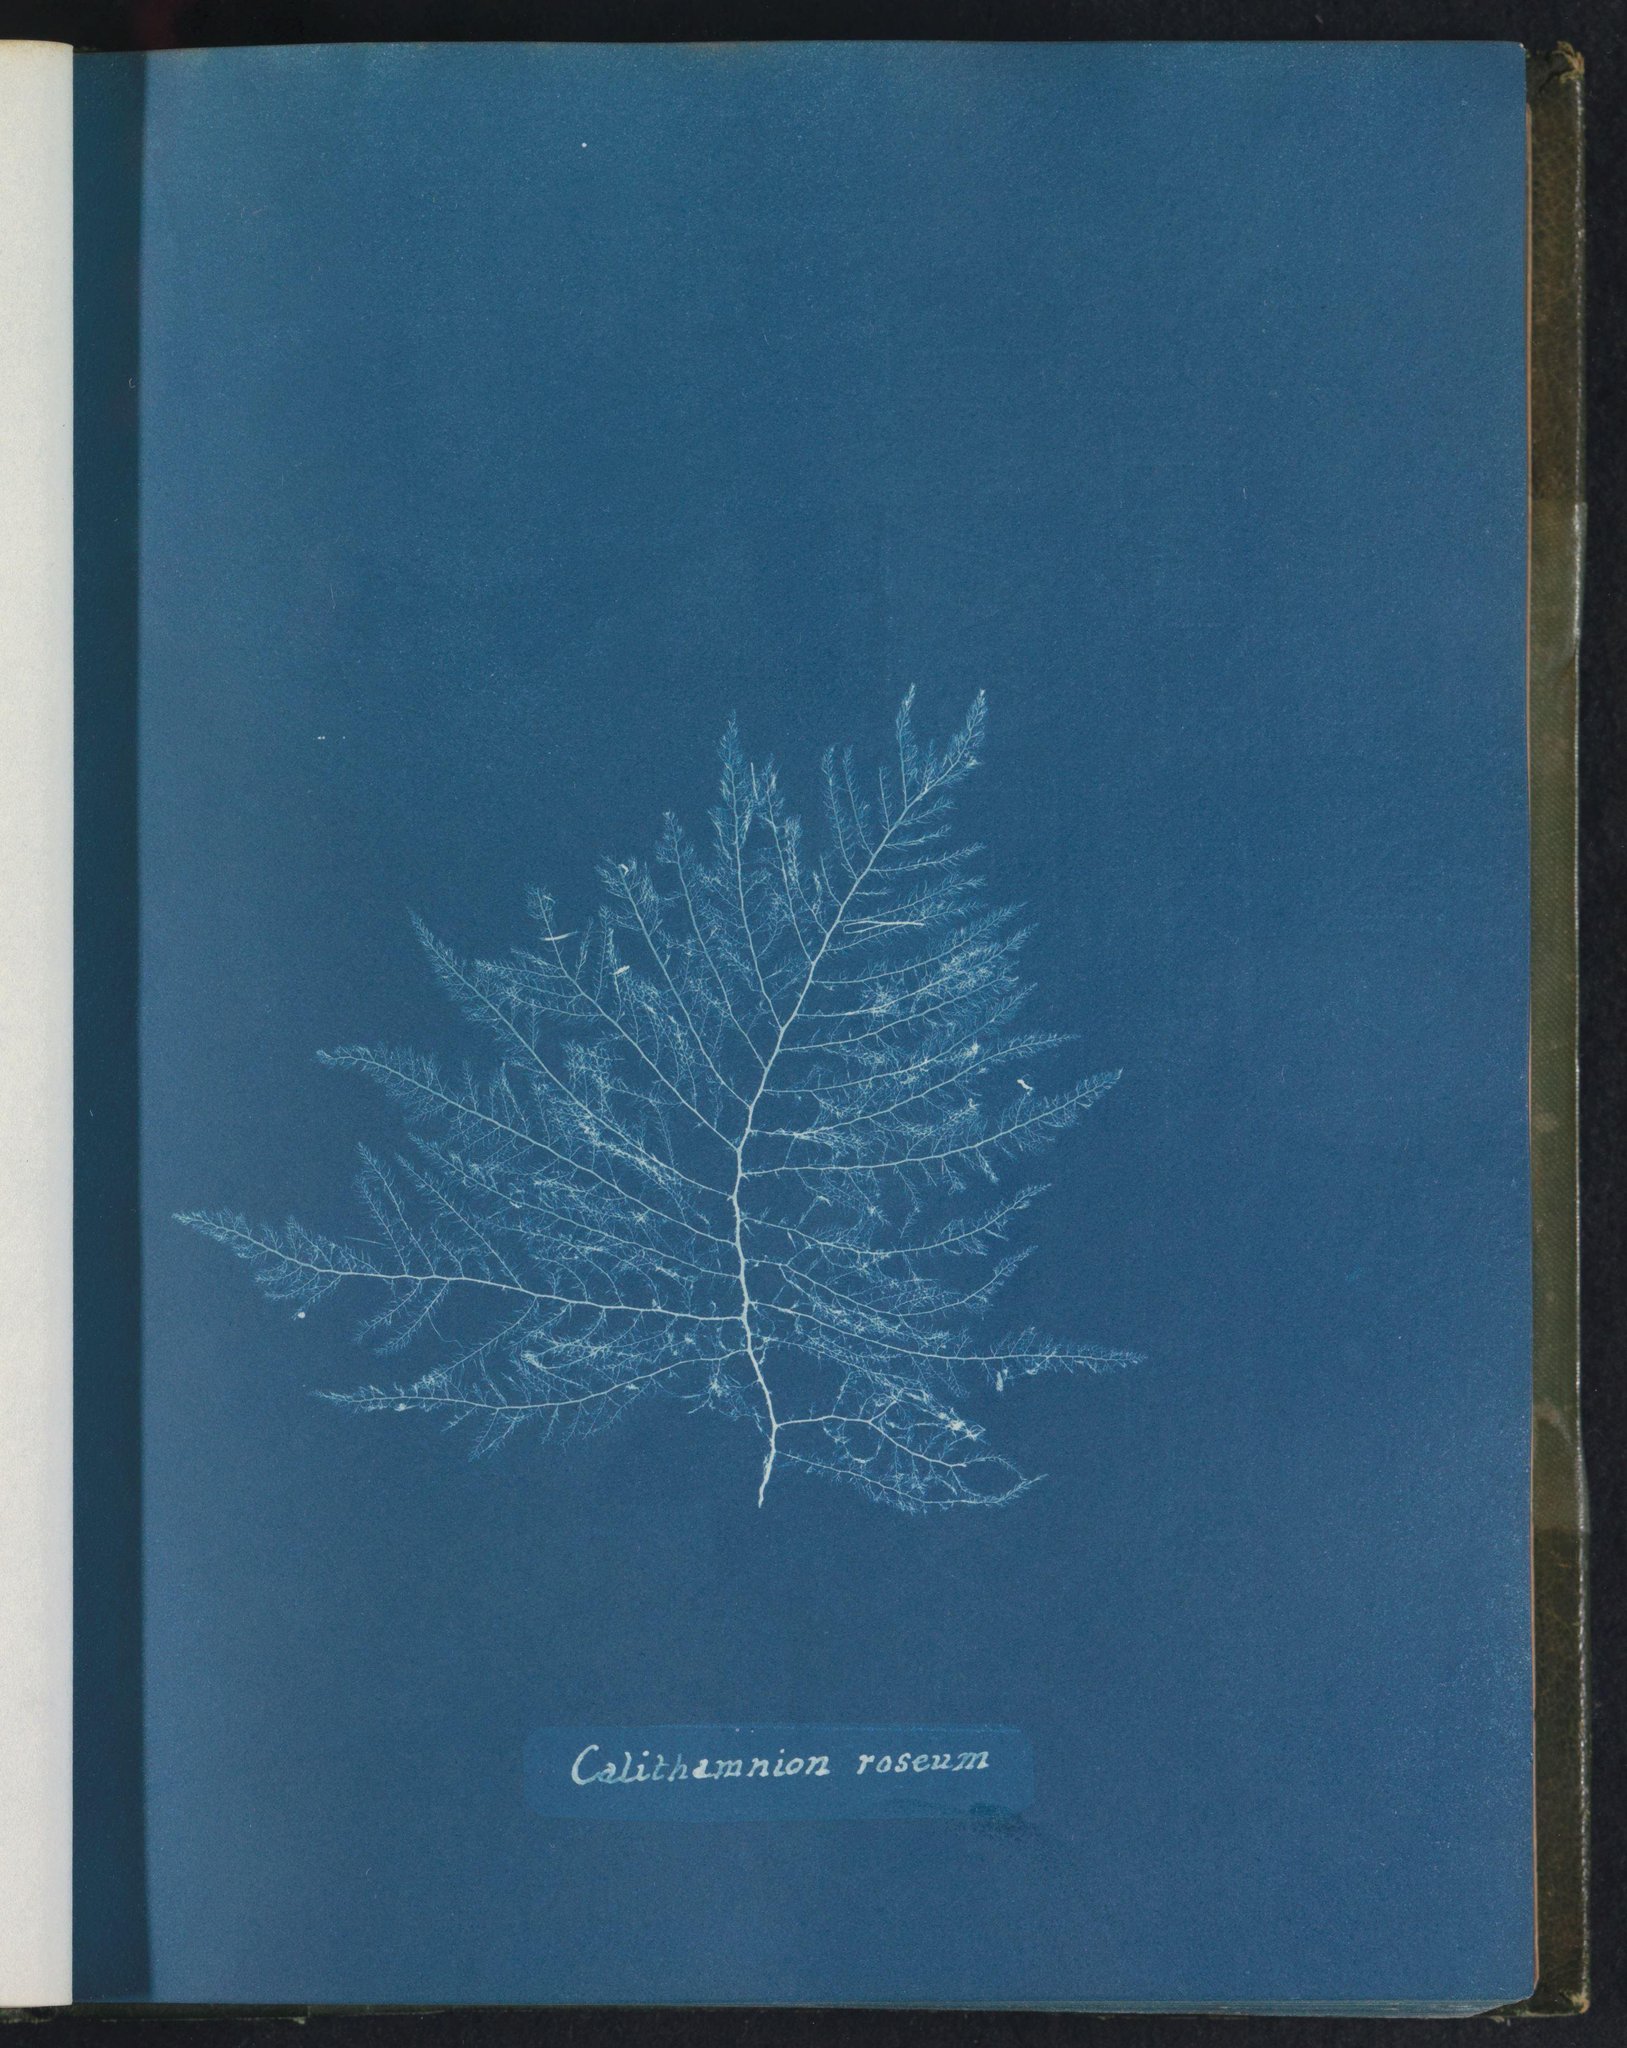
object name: photograph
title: Calithamnion roseum [= Callithamnion roseum]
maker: anna atkins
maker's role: fotograaf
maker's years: 1799-1871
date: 1843-1853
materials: photographic support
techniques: cyanotype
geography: united kingdom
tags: algae, seaweed